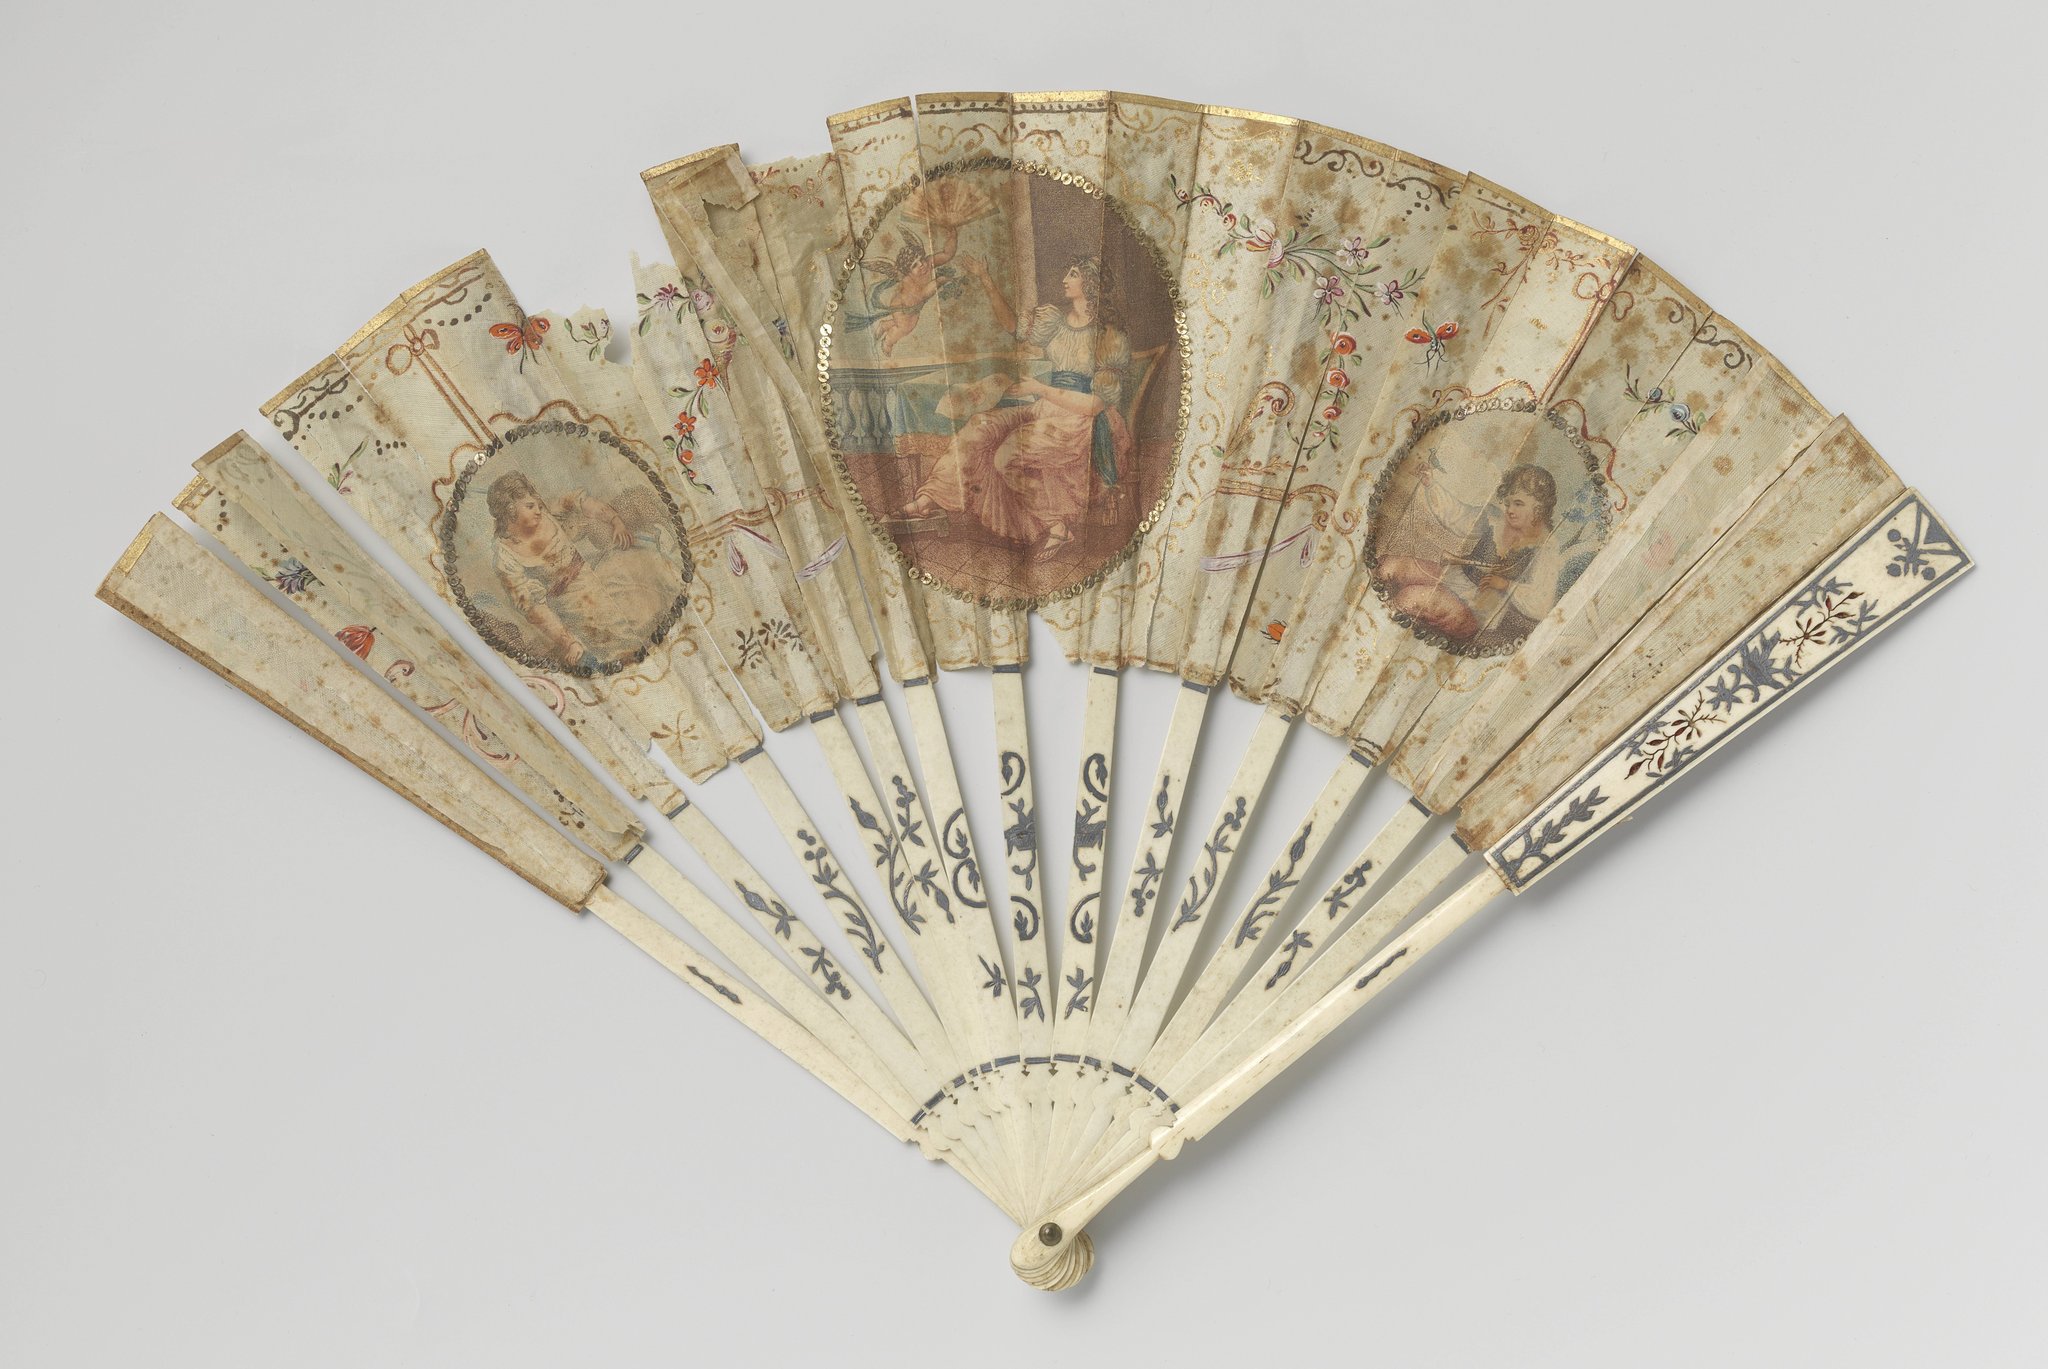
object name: vouwwaaier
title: Vouwwaaier met blad van zijde waarop een medaillon waarin zittende dame en putti met waaier geschilderd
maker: Anonymous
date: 1775-1800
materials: gouache, ivory, paint, silk, silver, watercolor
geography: netherlands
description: vouwwaaier met blad van zijde waarop een medaillon waarin een zittende dame en putti met waaier is geschilderd. De zijde op de vouwen is geheel vergaan, daarom is openen bijna onmogelijk. Montuur heeft 16 niet aaneengesloten benen van ivoor(?) en is ingelegd met zilver. Koperen sluitpin.